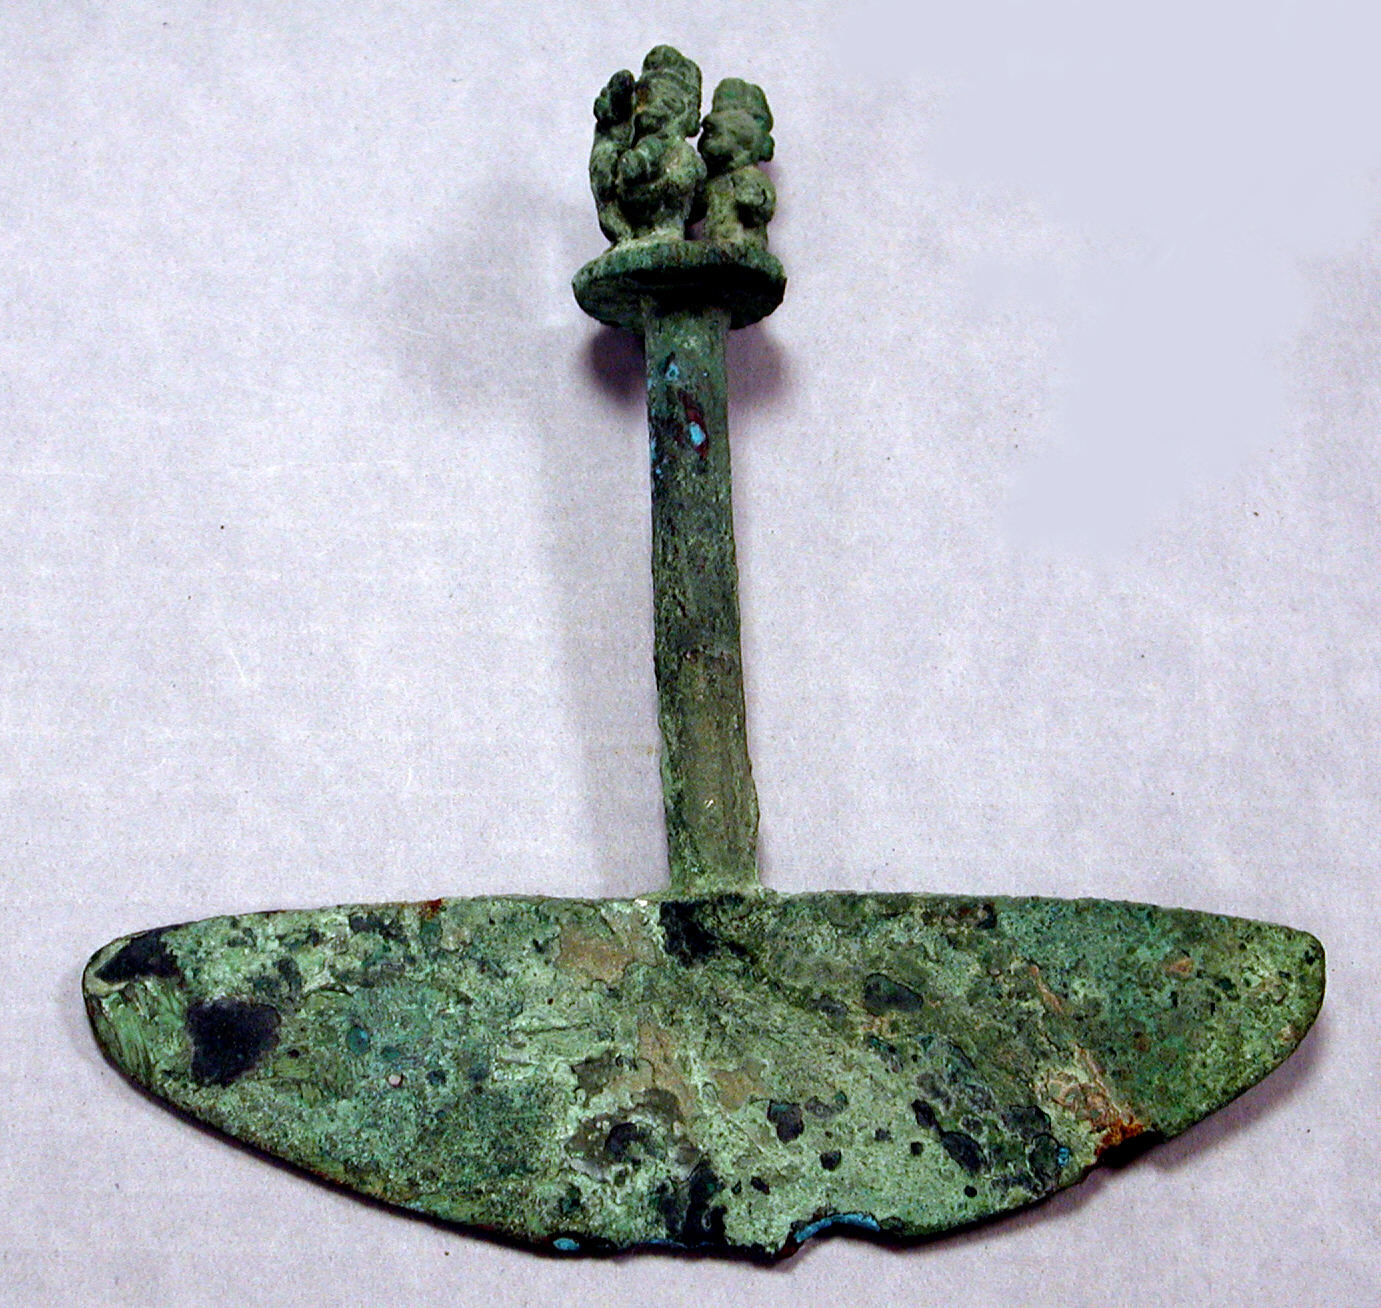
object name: knife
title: Tumi with Figure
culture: inca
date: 1401-1533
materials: copper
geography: peru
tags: human figures